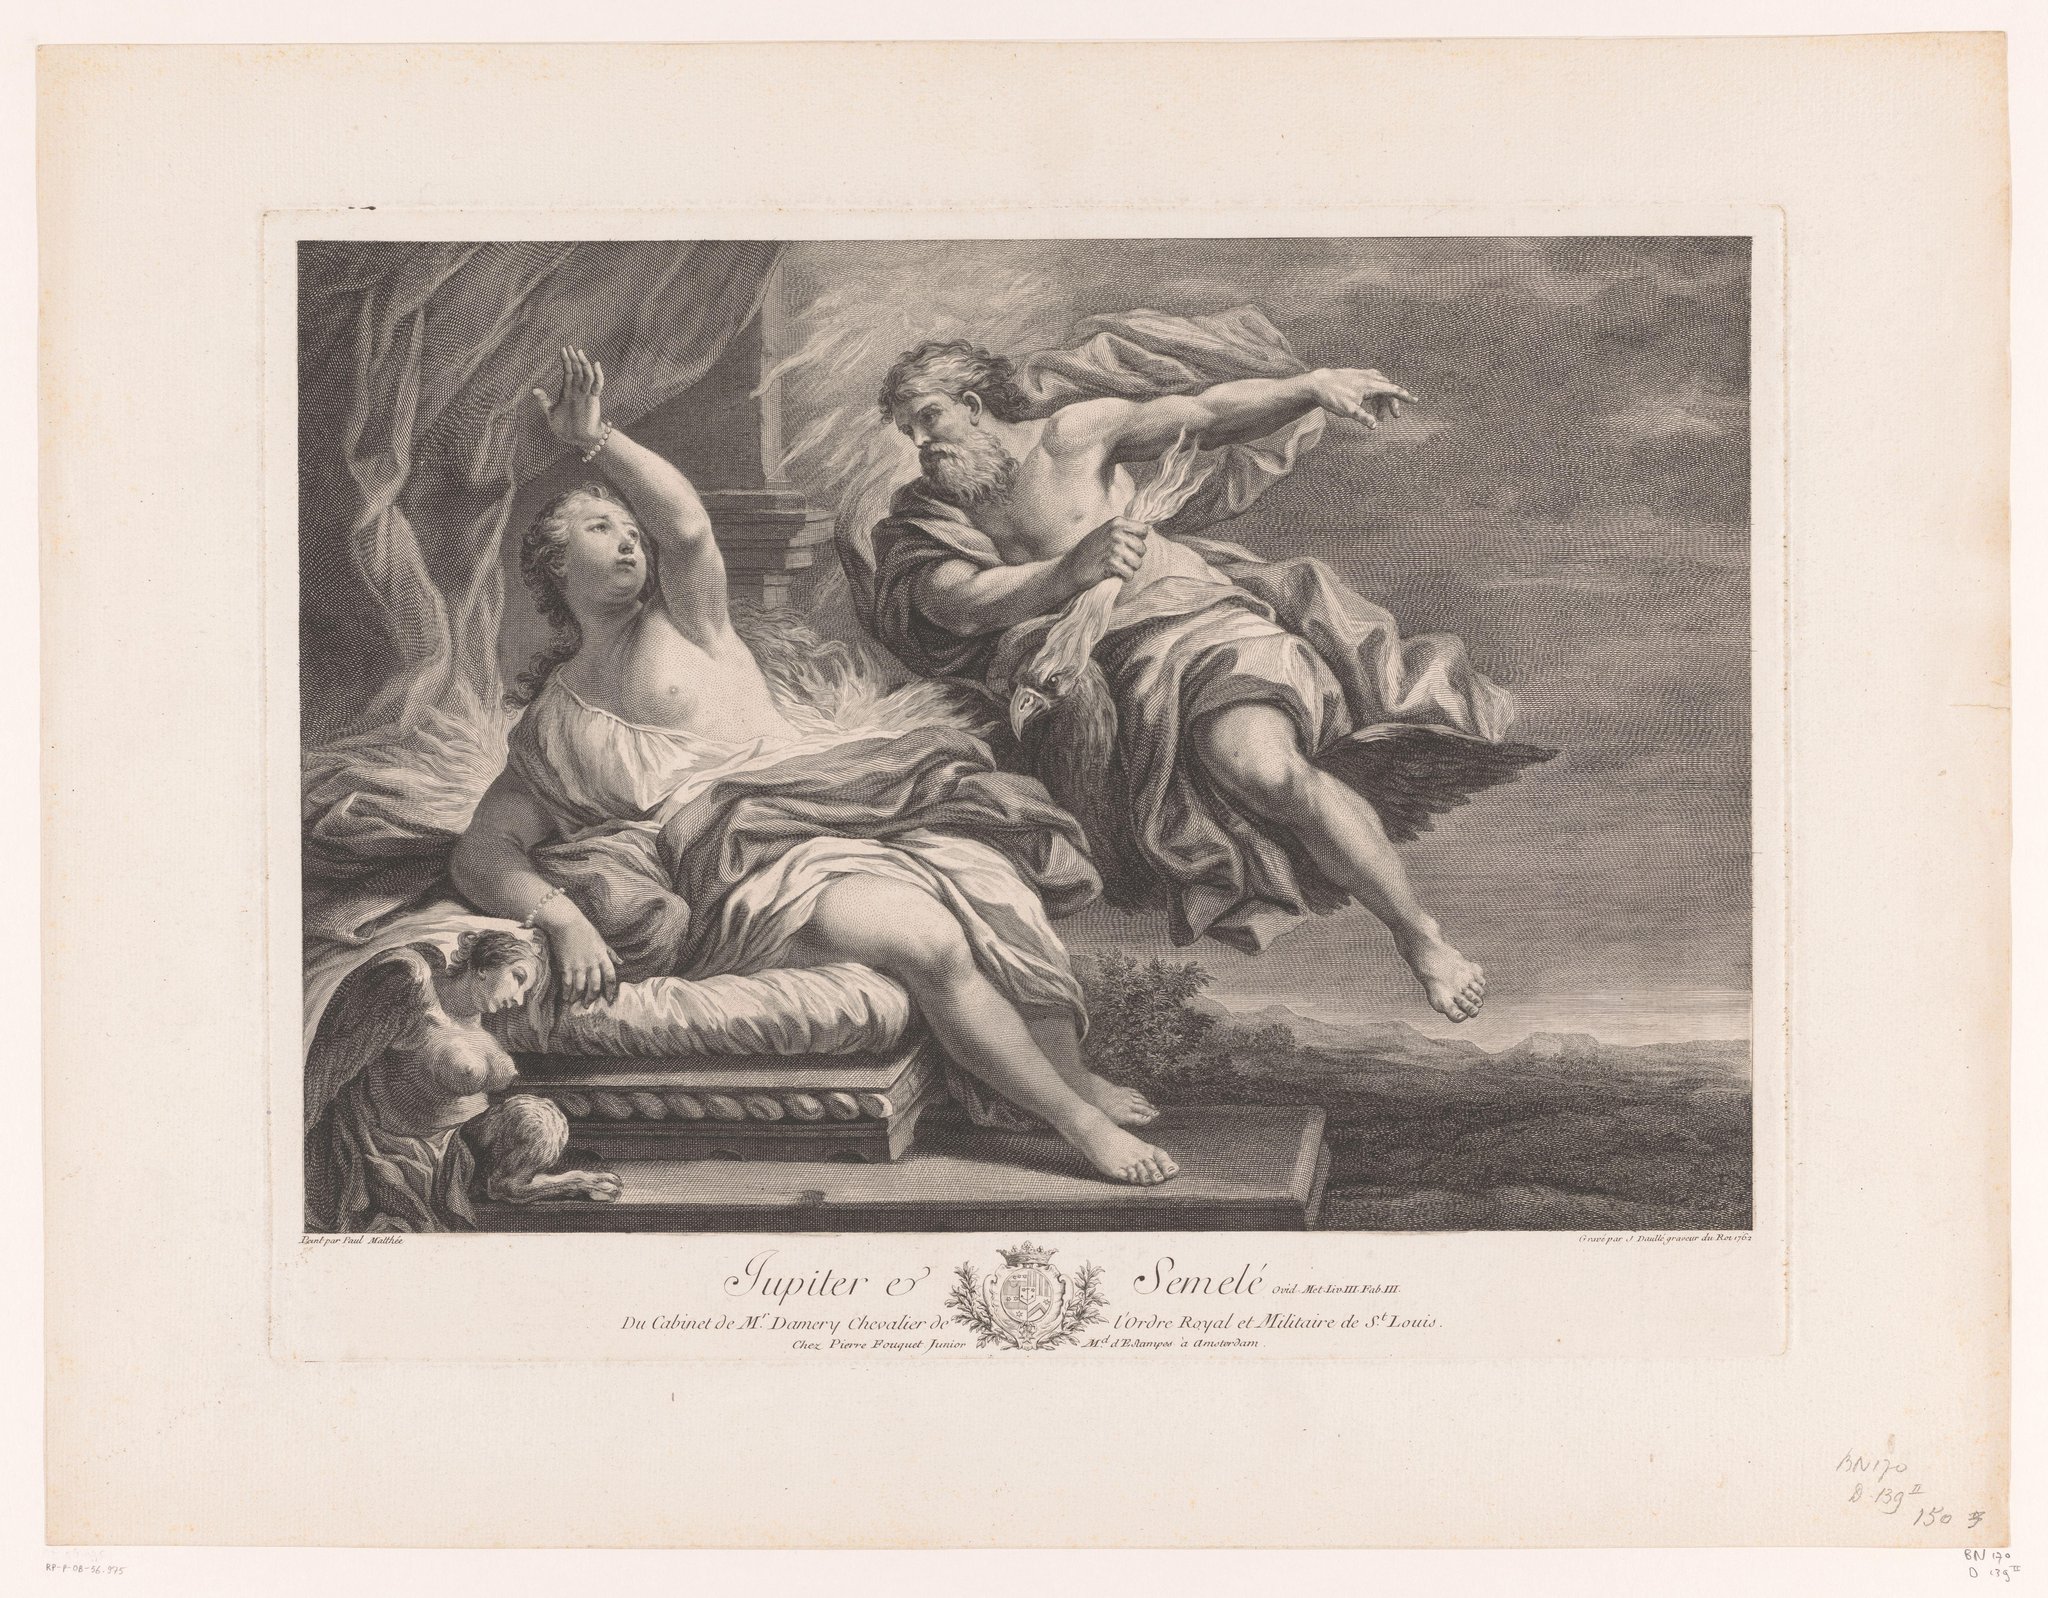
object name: print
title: Jupiter en Semele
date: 1762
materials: paper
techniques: engraving, etching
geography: amsterdam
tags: jupiter wooing semele, armorial bearing, heraldry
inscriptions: collector's mark: Lugt 240